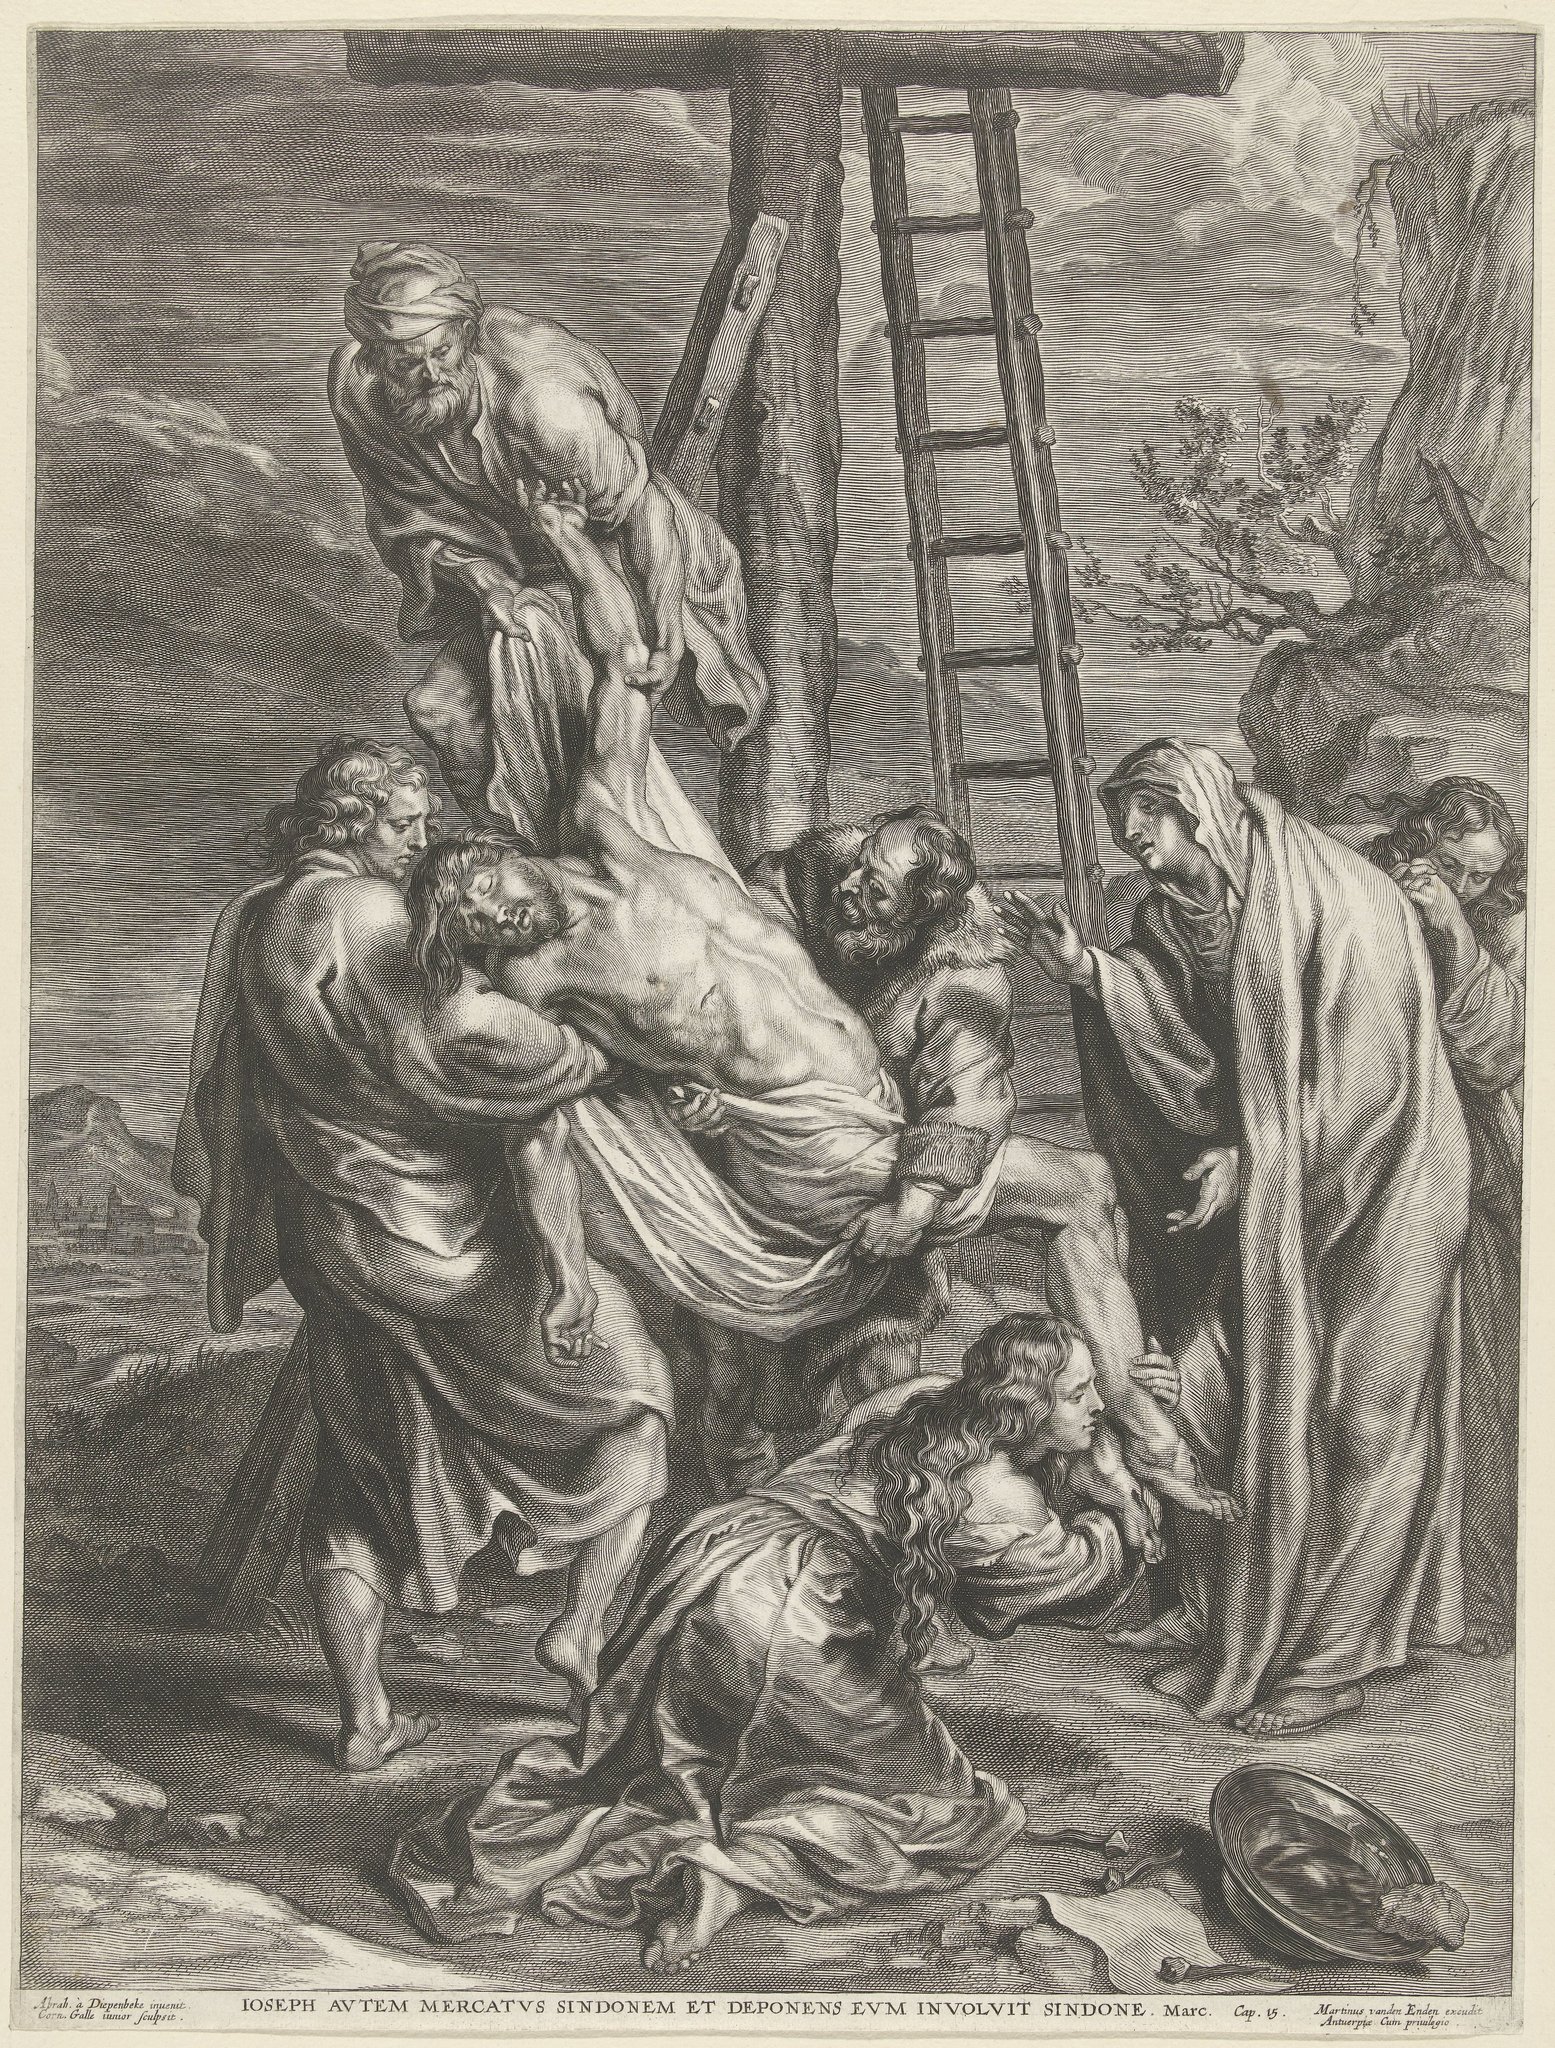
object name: print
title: Kruisafneming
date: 1638-1650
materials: paper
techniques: engraving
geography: antwerp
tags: descent from the cross: christ is taken down from the cross, usually by nicodemus and joseph of arimathaea who are standing on the ladders (both arms of christ detached)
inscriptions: collector's mark: Lugt 240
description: Jozef van Arimatea, Nikodemus en Johannes halen het lichaam van Christus van het kruis. Nikodemus staat op een ladder en houdt een arm van Christus vast. Johannes en Jozef nemen het lichaam van Christus in ontvangst. Maria Magdalena knielt op de grond en grijpt naar Christus voeten.